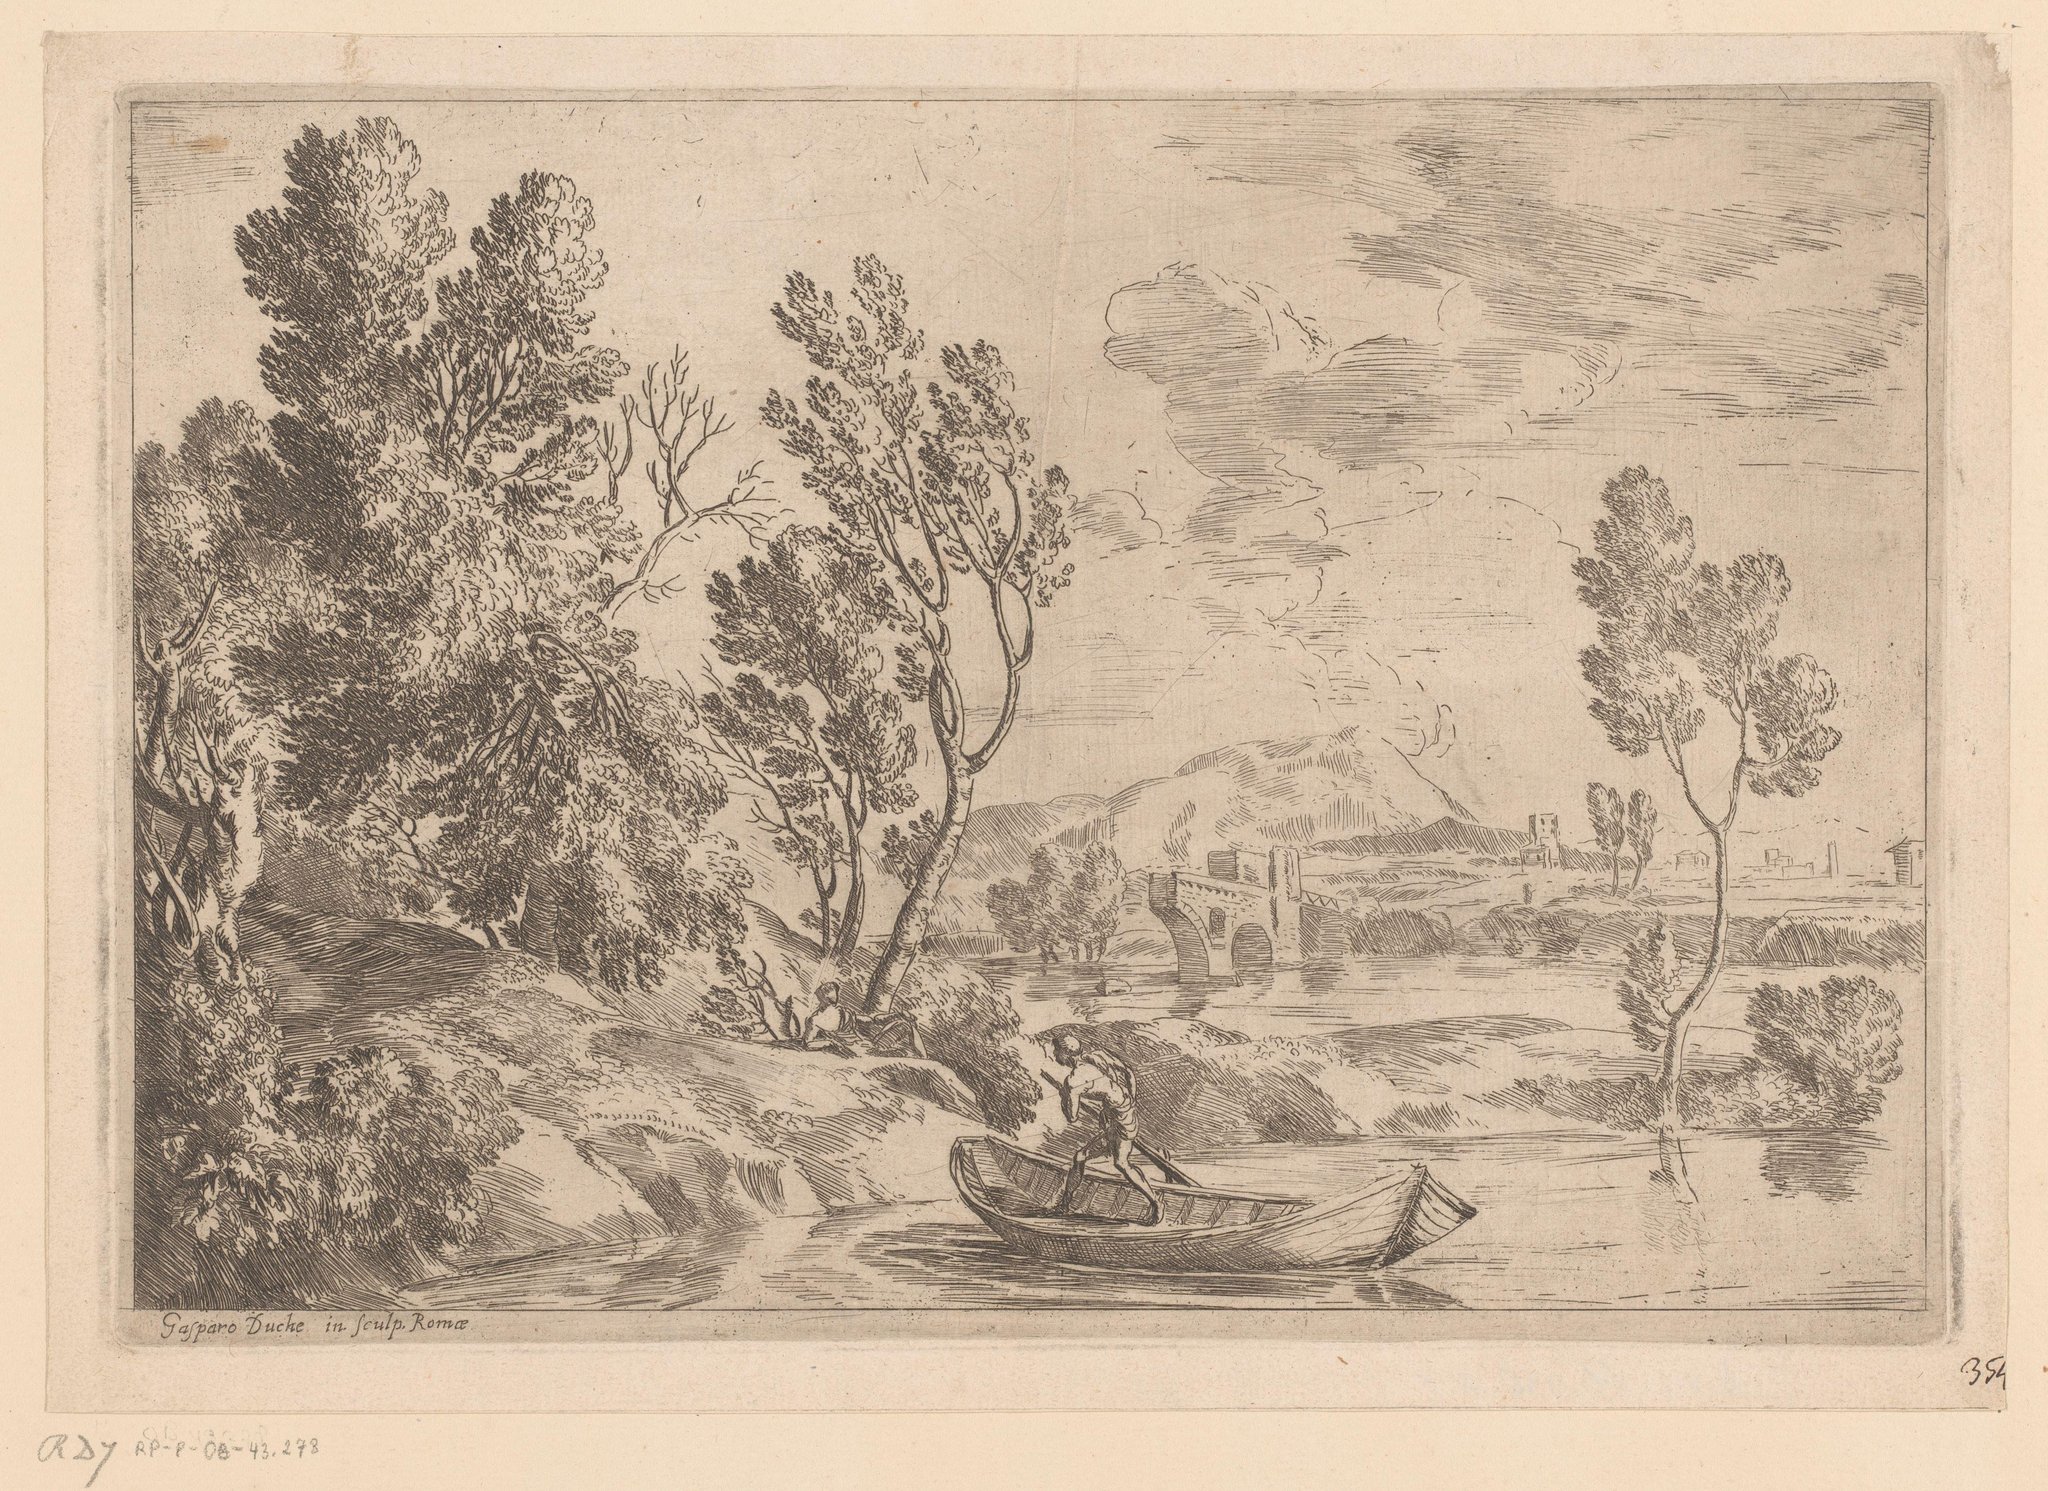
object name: print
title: Rivierlandschap met man in sloep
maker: gaspard dughet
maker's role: draughtsman, painter, print maker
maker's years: 1615-1675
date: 1625-1675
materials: paper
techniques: drypoint, etching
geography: rome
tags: river, rowing-boat, canoe, etc., bridge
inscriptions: collector's mark: Lugt 240